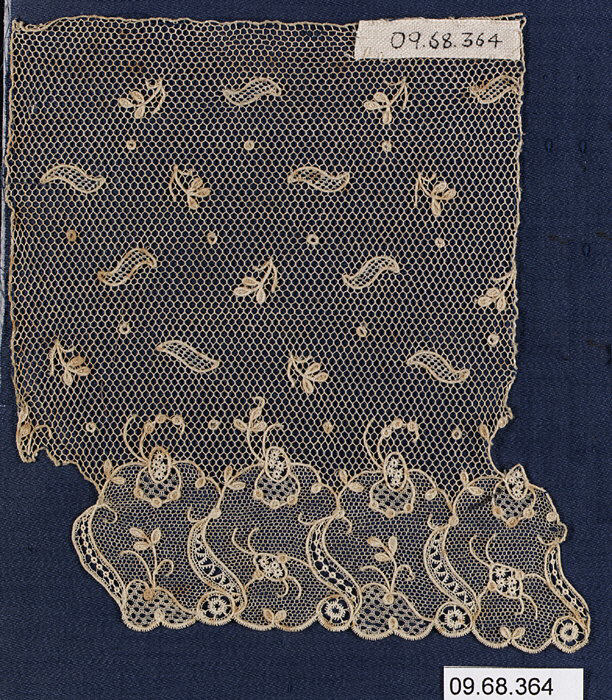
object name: fragment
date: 1801-1900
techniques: lace